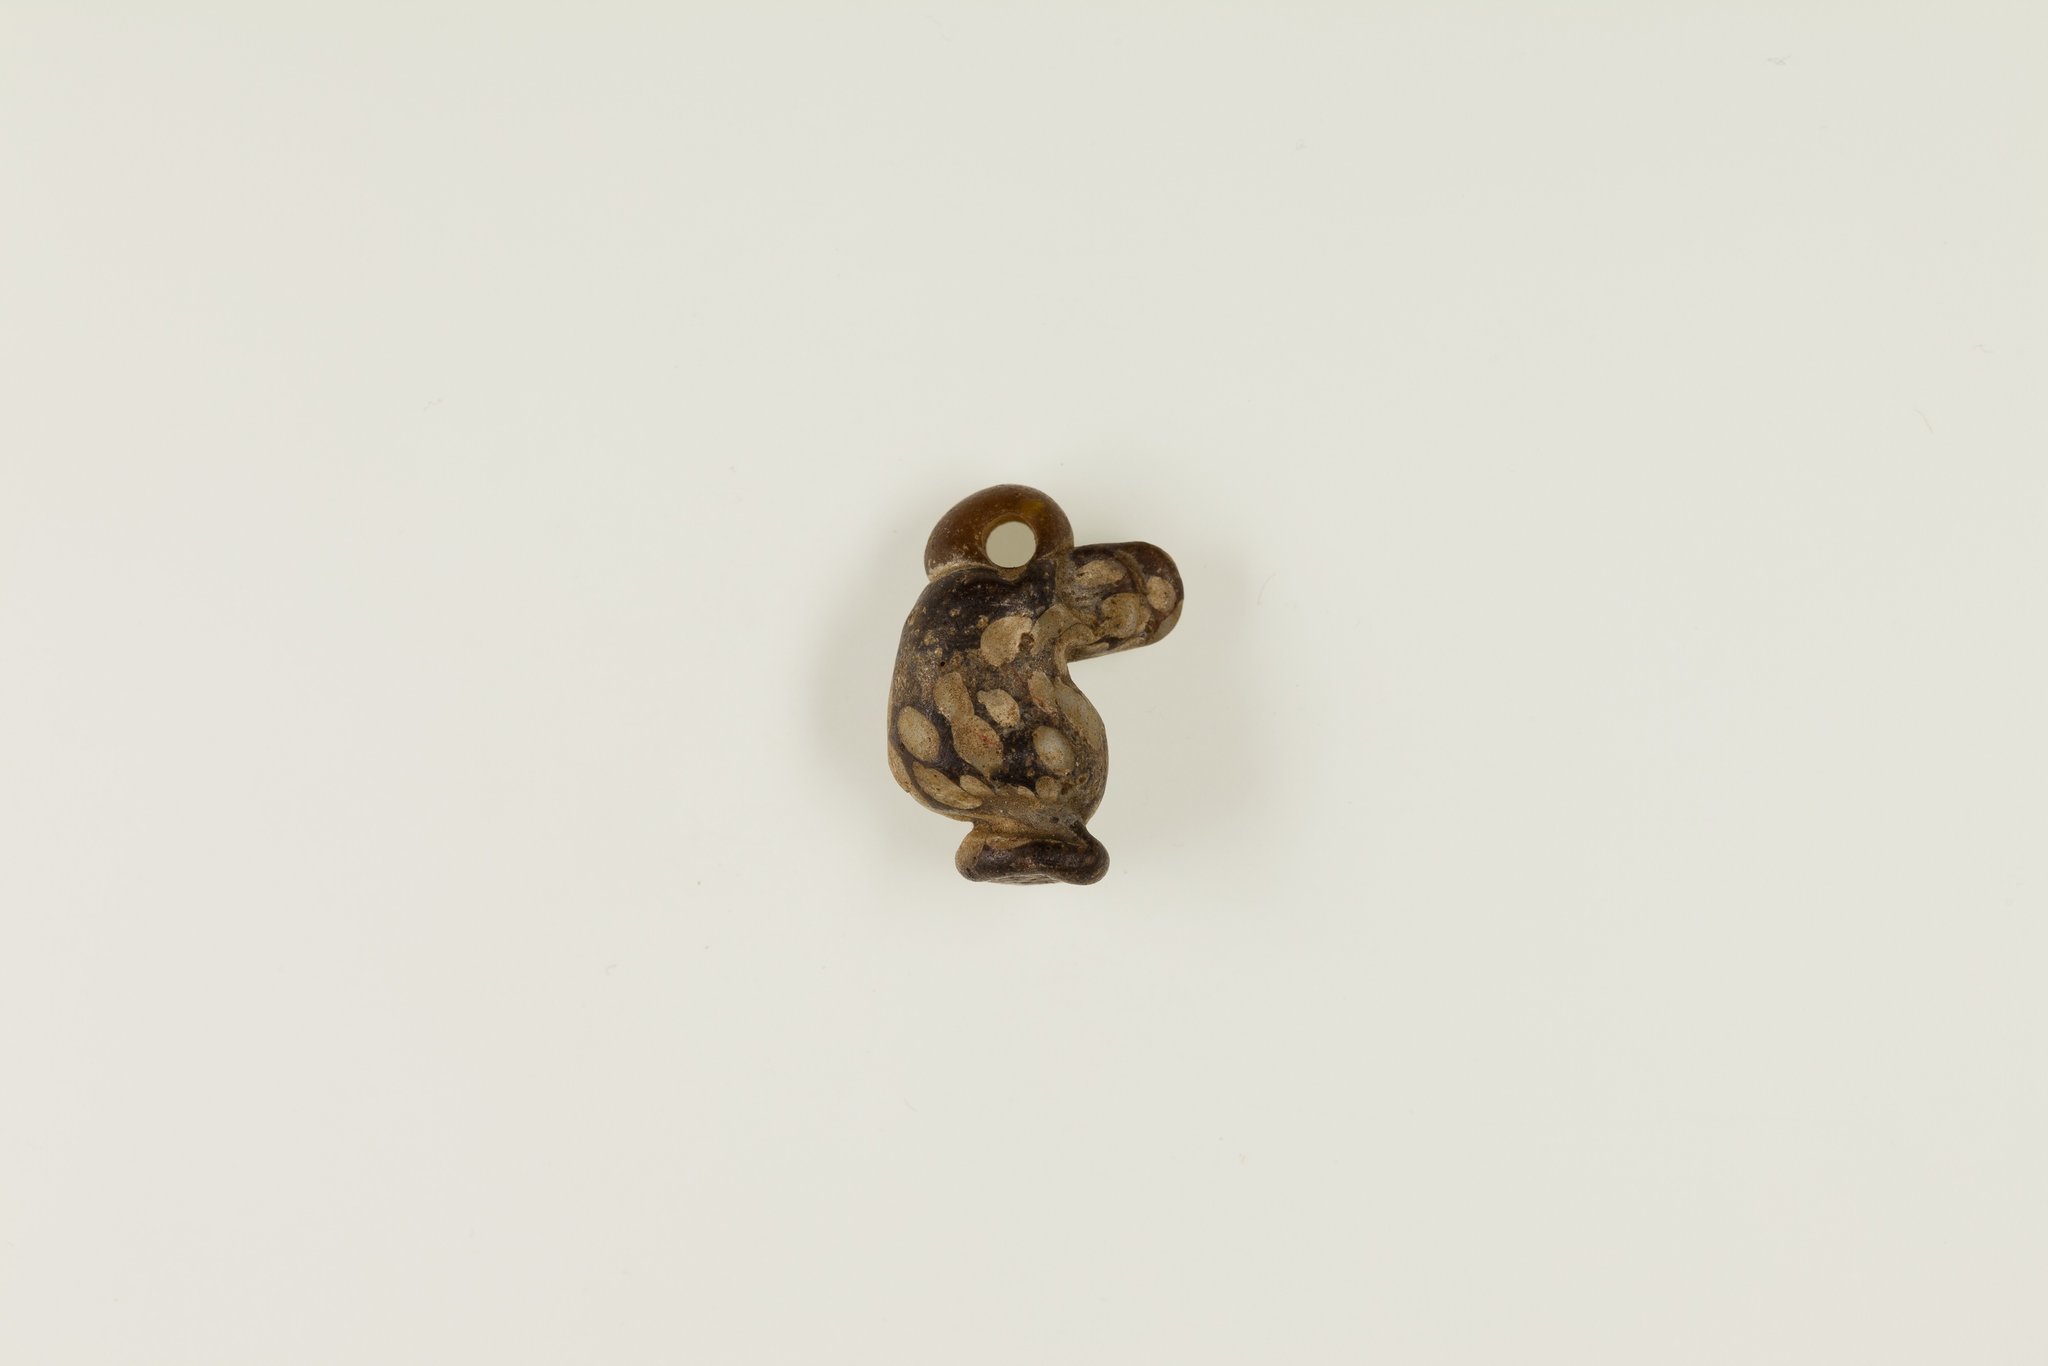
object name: pendant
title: Amulet, Taweret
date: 100 BCE-100 CE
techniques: mosaic glass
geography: egypt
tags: taweret